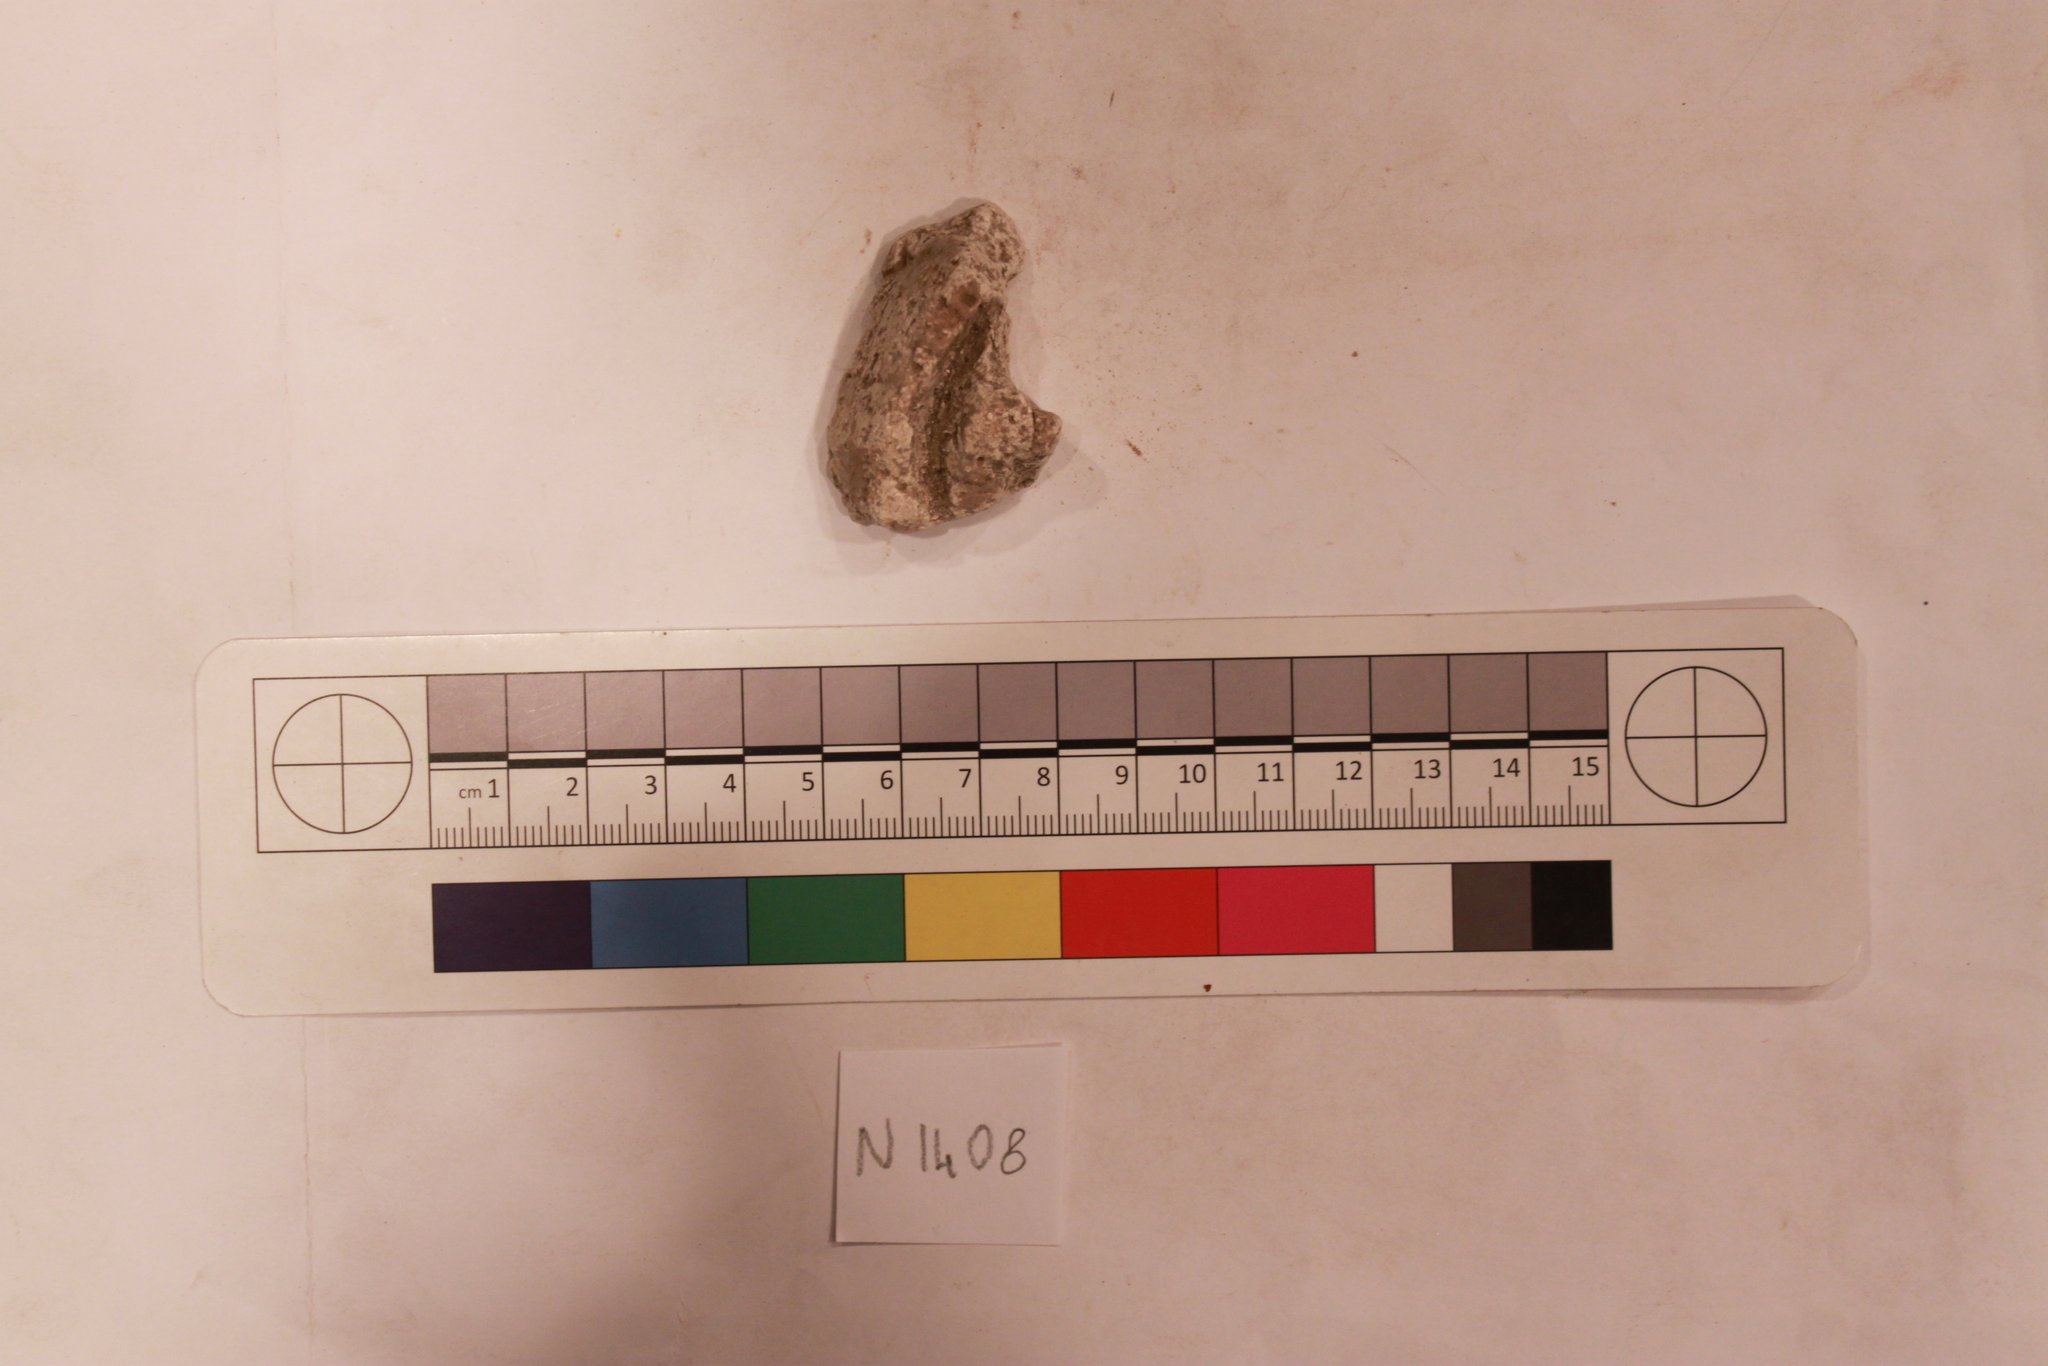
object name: fragment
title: Stucco Fragment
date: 701-1200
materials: plaster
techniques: carving, painting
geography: iran